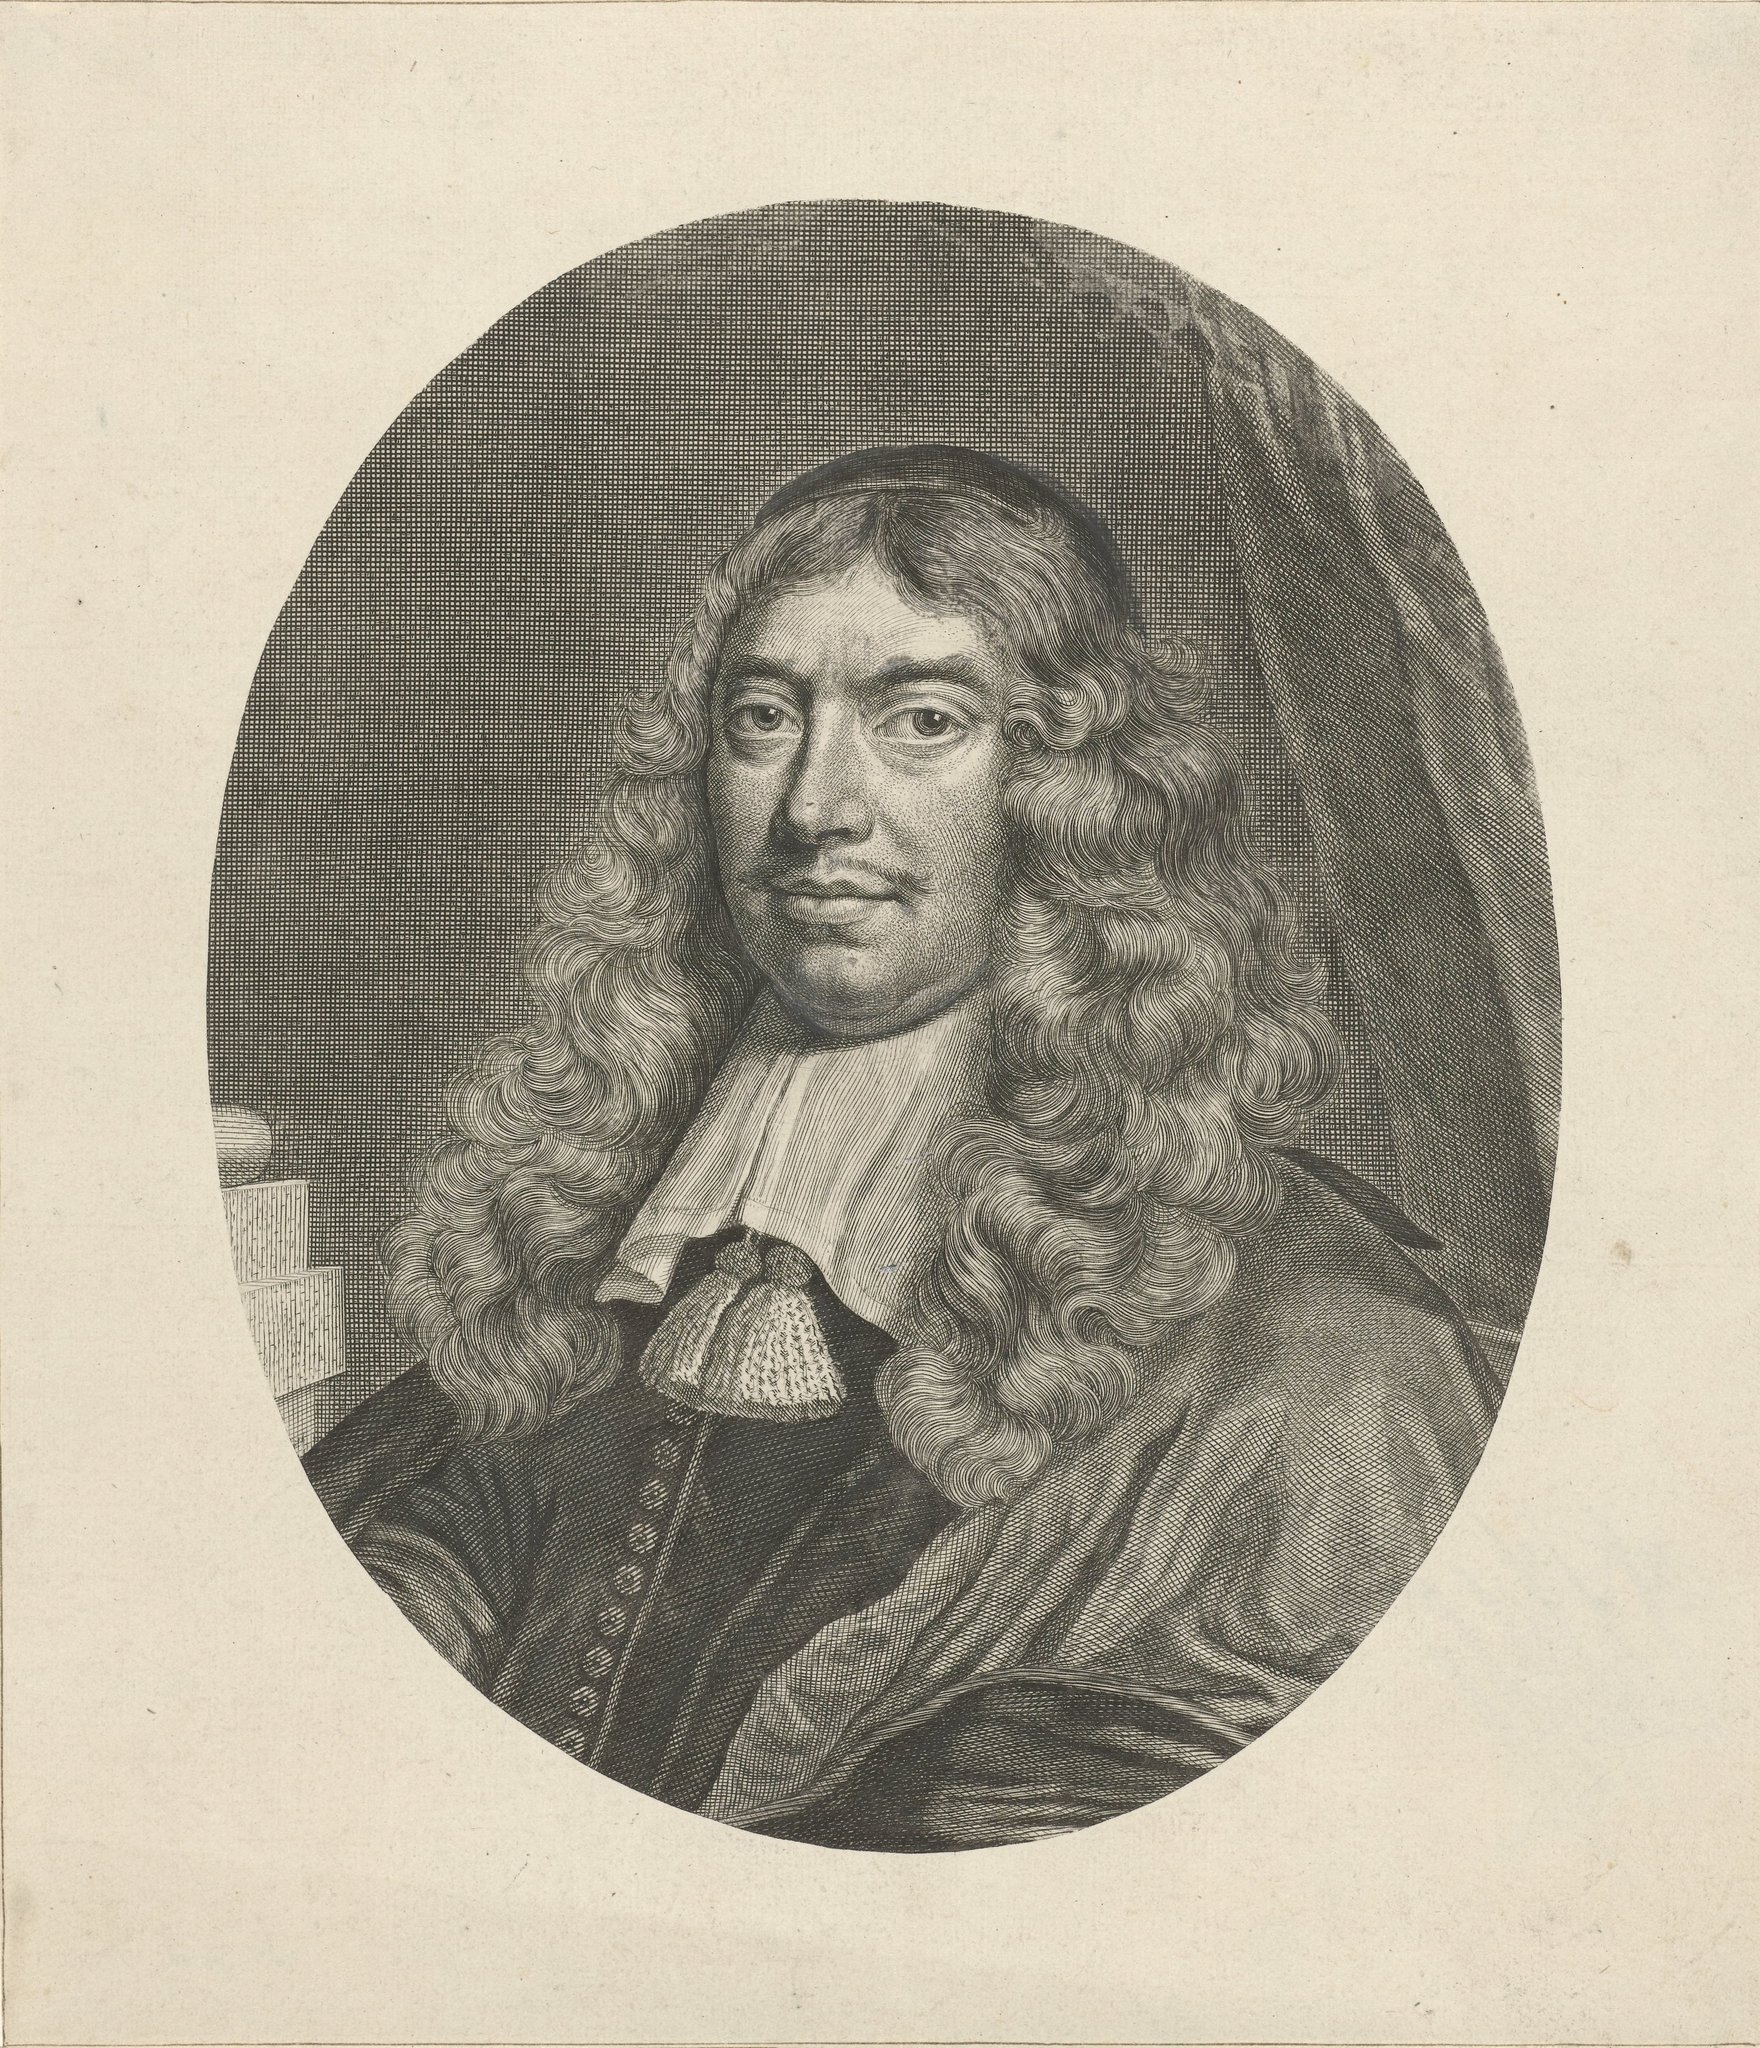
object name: print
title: Portret van Gillis Valckenier op 50-jarige leeftijd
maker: theodor matham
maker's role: draughtsman, print maker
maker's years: 1605-1676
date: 1674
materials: paper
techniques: engraving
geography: amsterdam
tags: historical persons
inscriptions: collector's mark: Lugt 2228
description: Buste van Gillis Valckenier, burgemeester van Amsterdam.